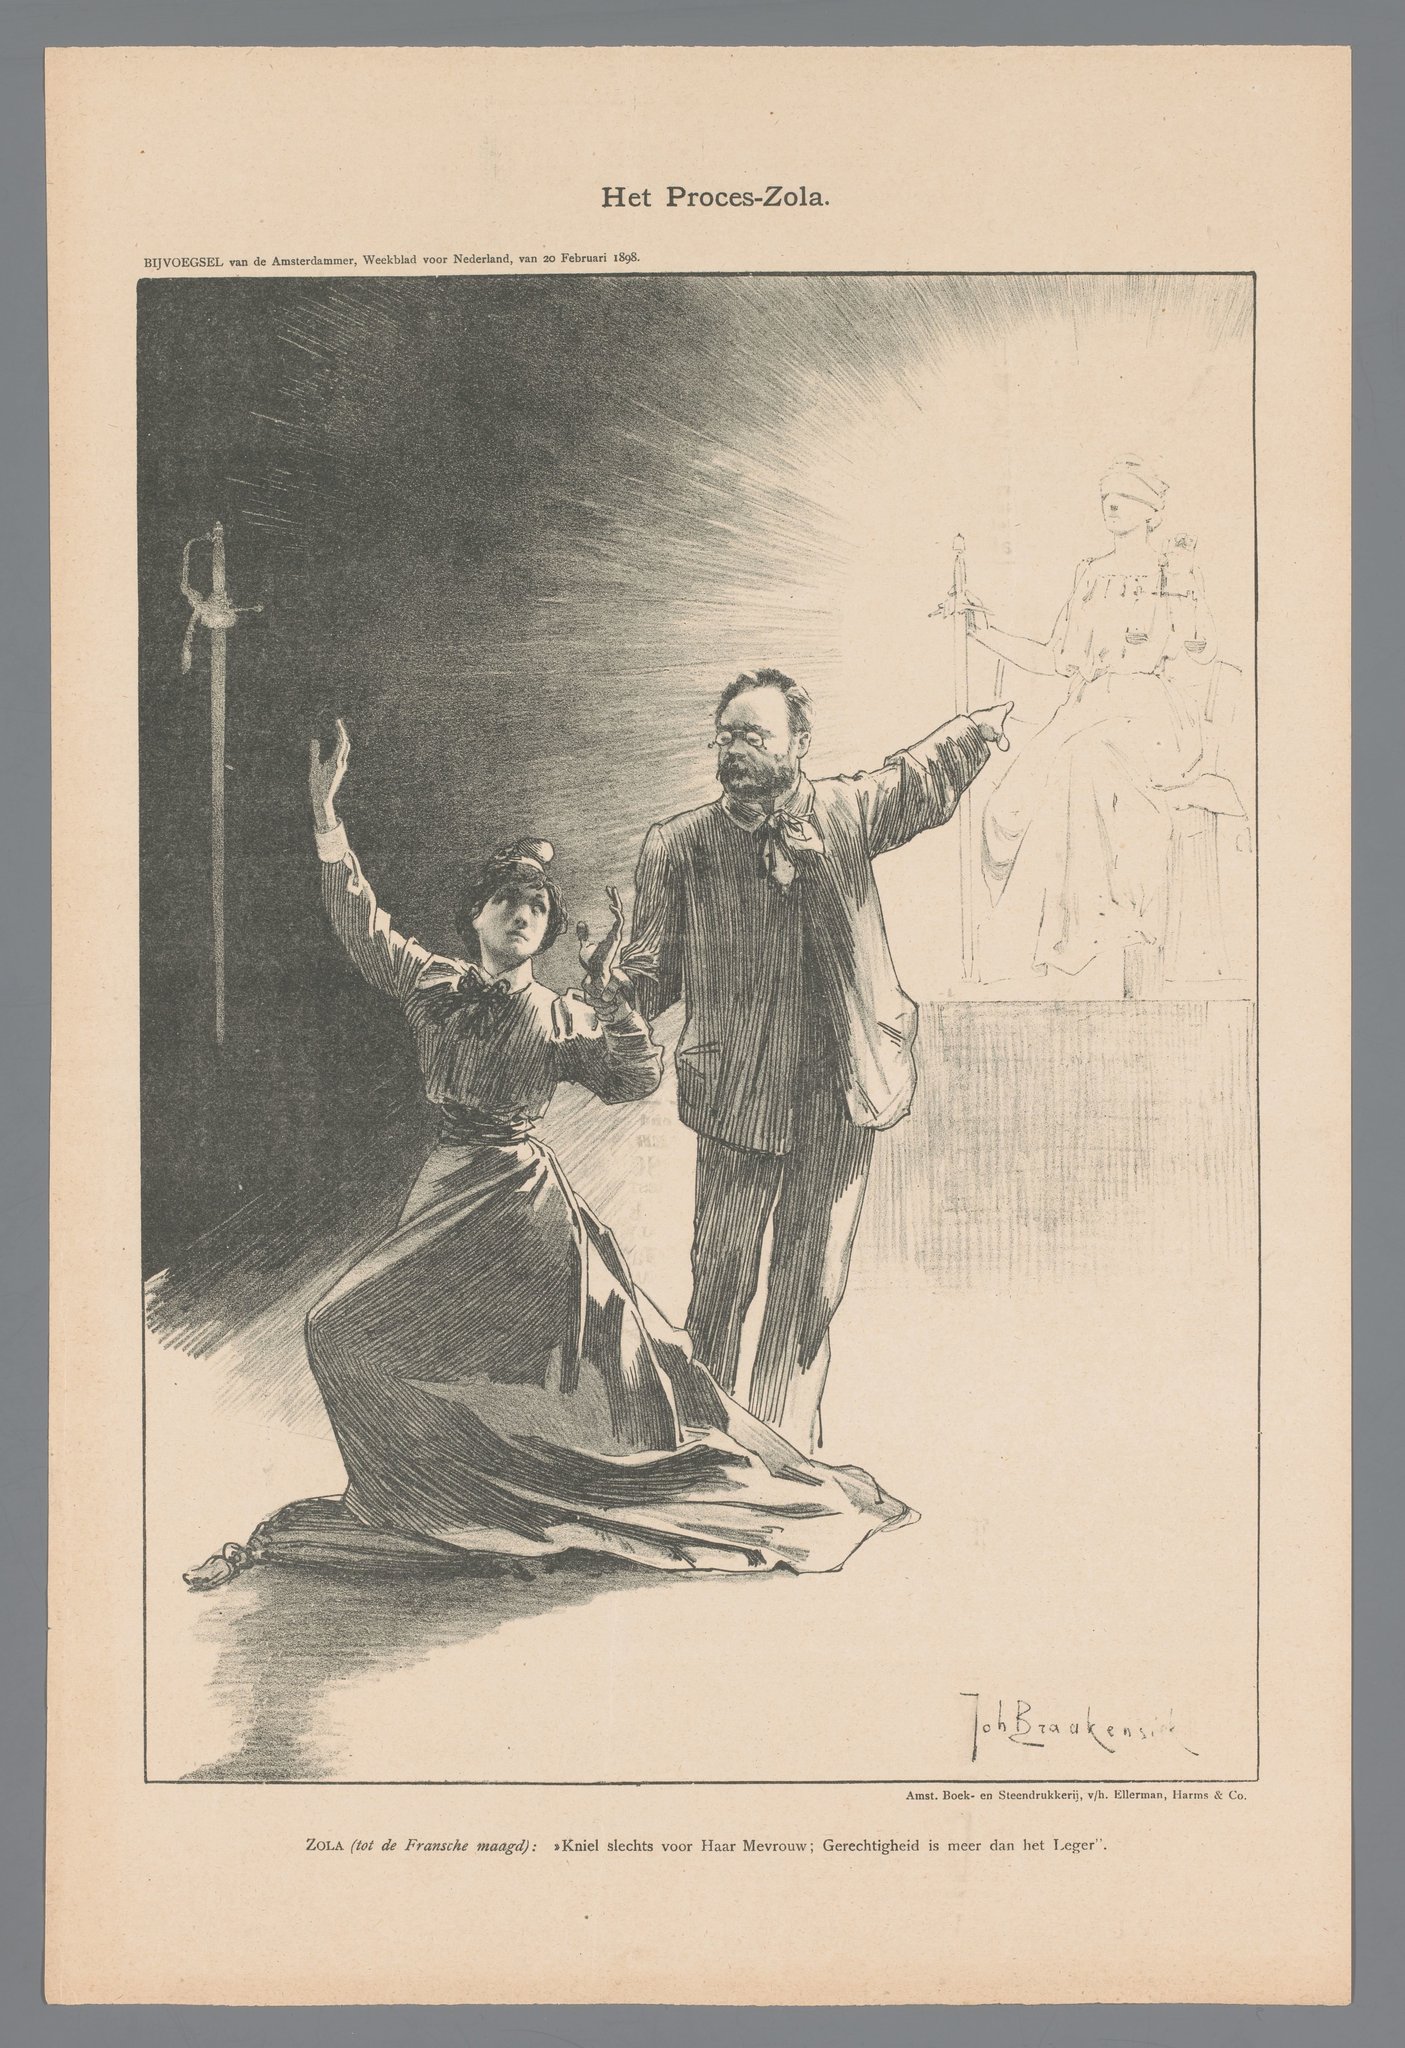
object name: cartoon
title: Het Proces-Zola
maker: johan braakensiek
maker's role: draughtsman, print maker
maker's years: 1858-1940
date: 1898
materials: paper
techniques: lithograph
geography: amsterdam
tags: paris, emile zola, historical persons, justitia (justice) as roman personification, personifications of countries, nations, states, districts, etc. (+ nation; national), political caricatures and satires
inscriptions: date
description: Prent uit het bijvoegsel van: De Amsterdammer. Weekblad voor Nederland, 20 februari 1898.